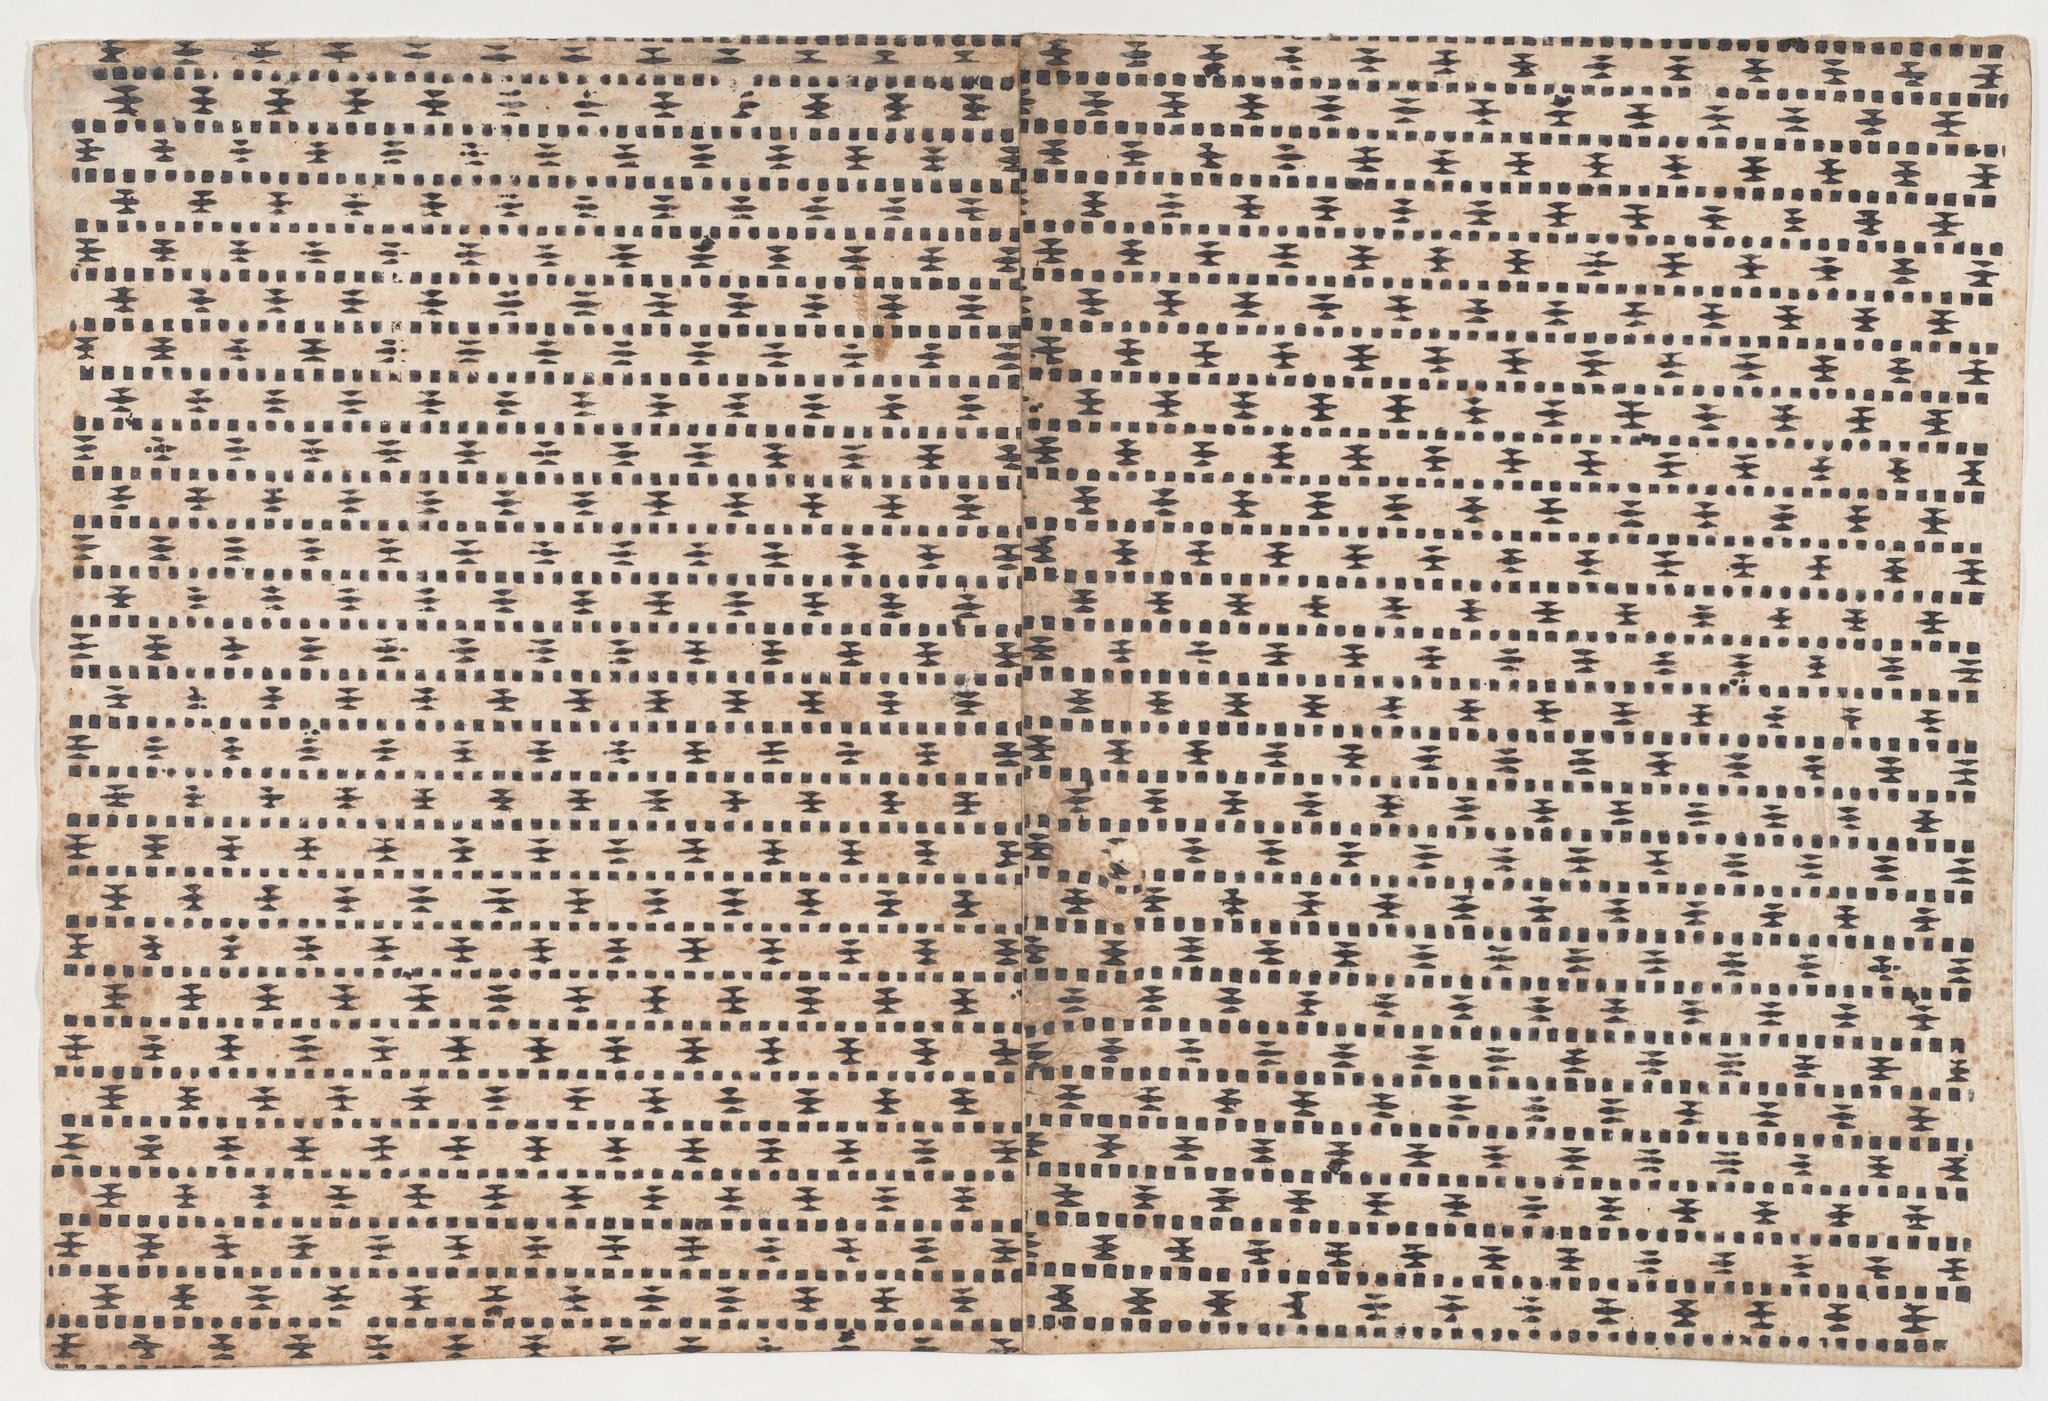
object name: print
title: Sheet with overall geometric pattern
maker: Anonymous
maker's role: artist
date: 1801-1900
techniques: relief print